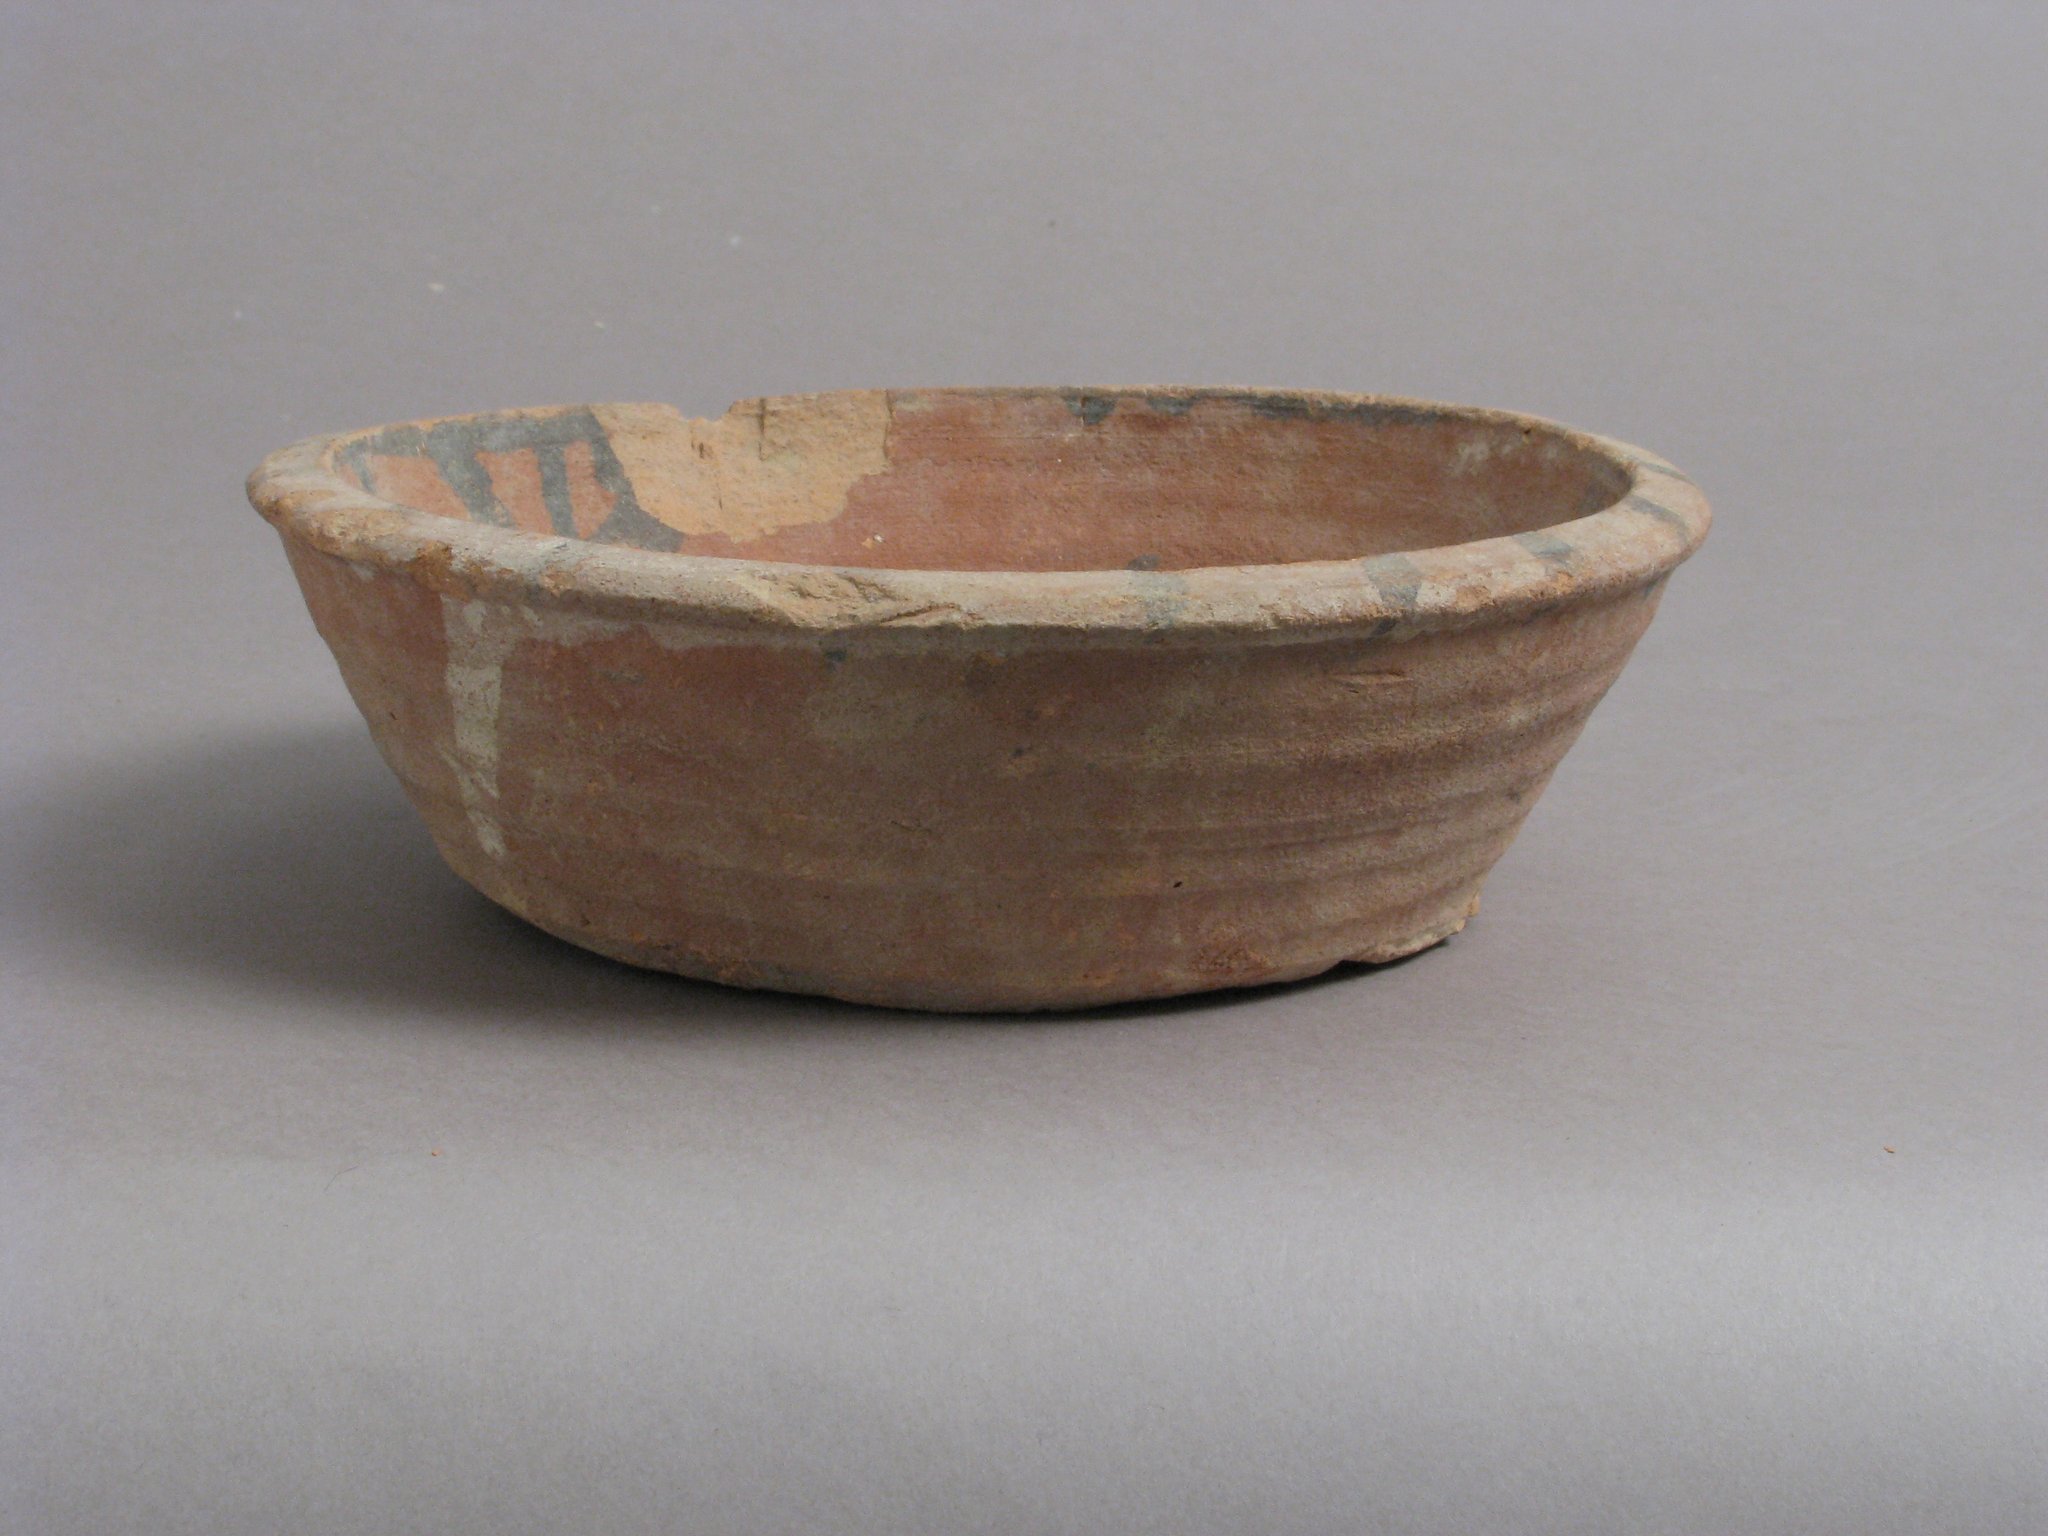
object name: bowl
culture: coptic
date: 301-700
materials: earthenware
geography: egypt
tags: bowls